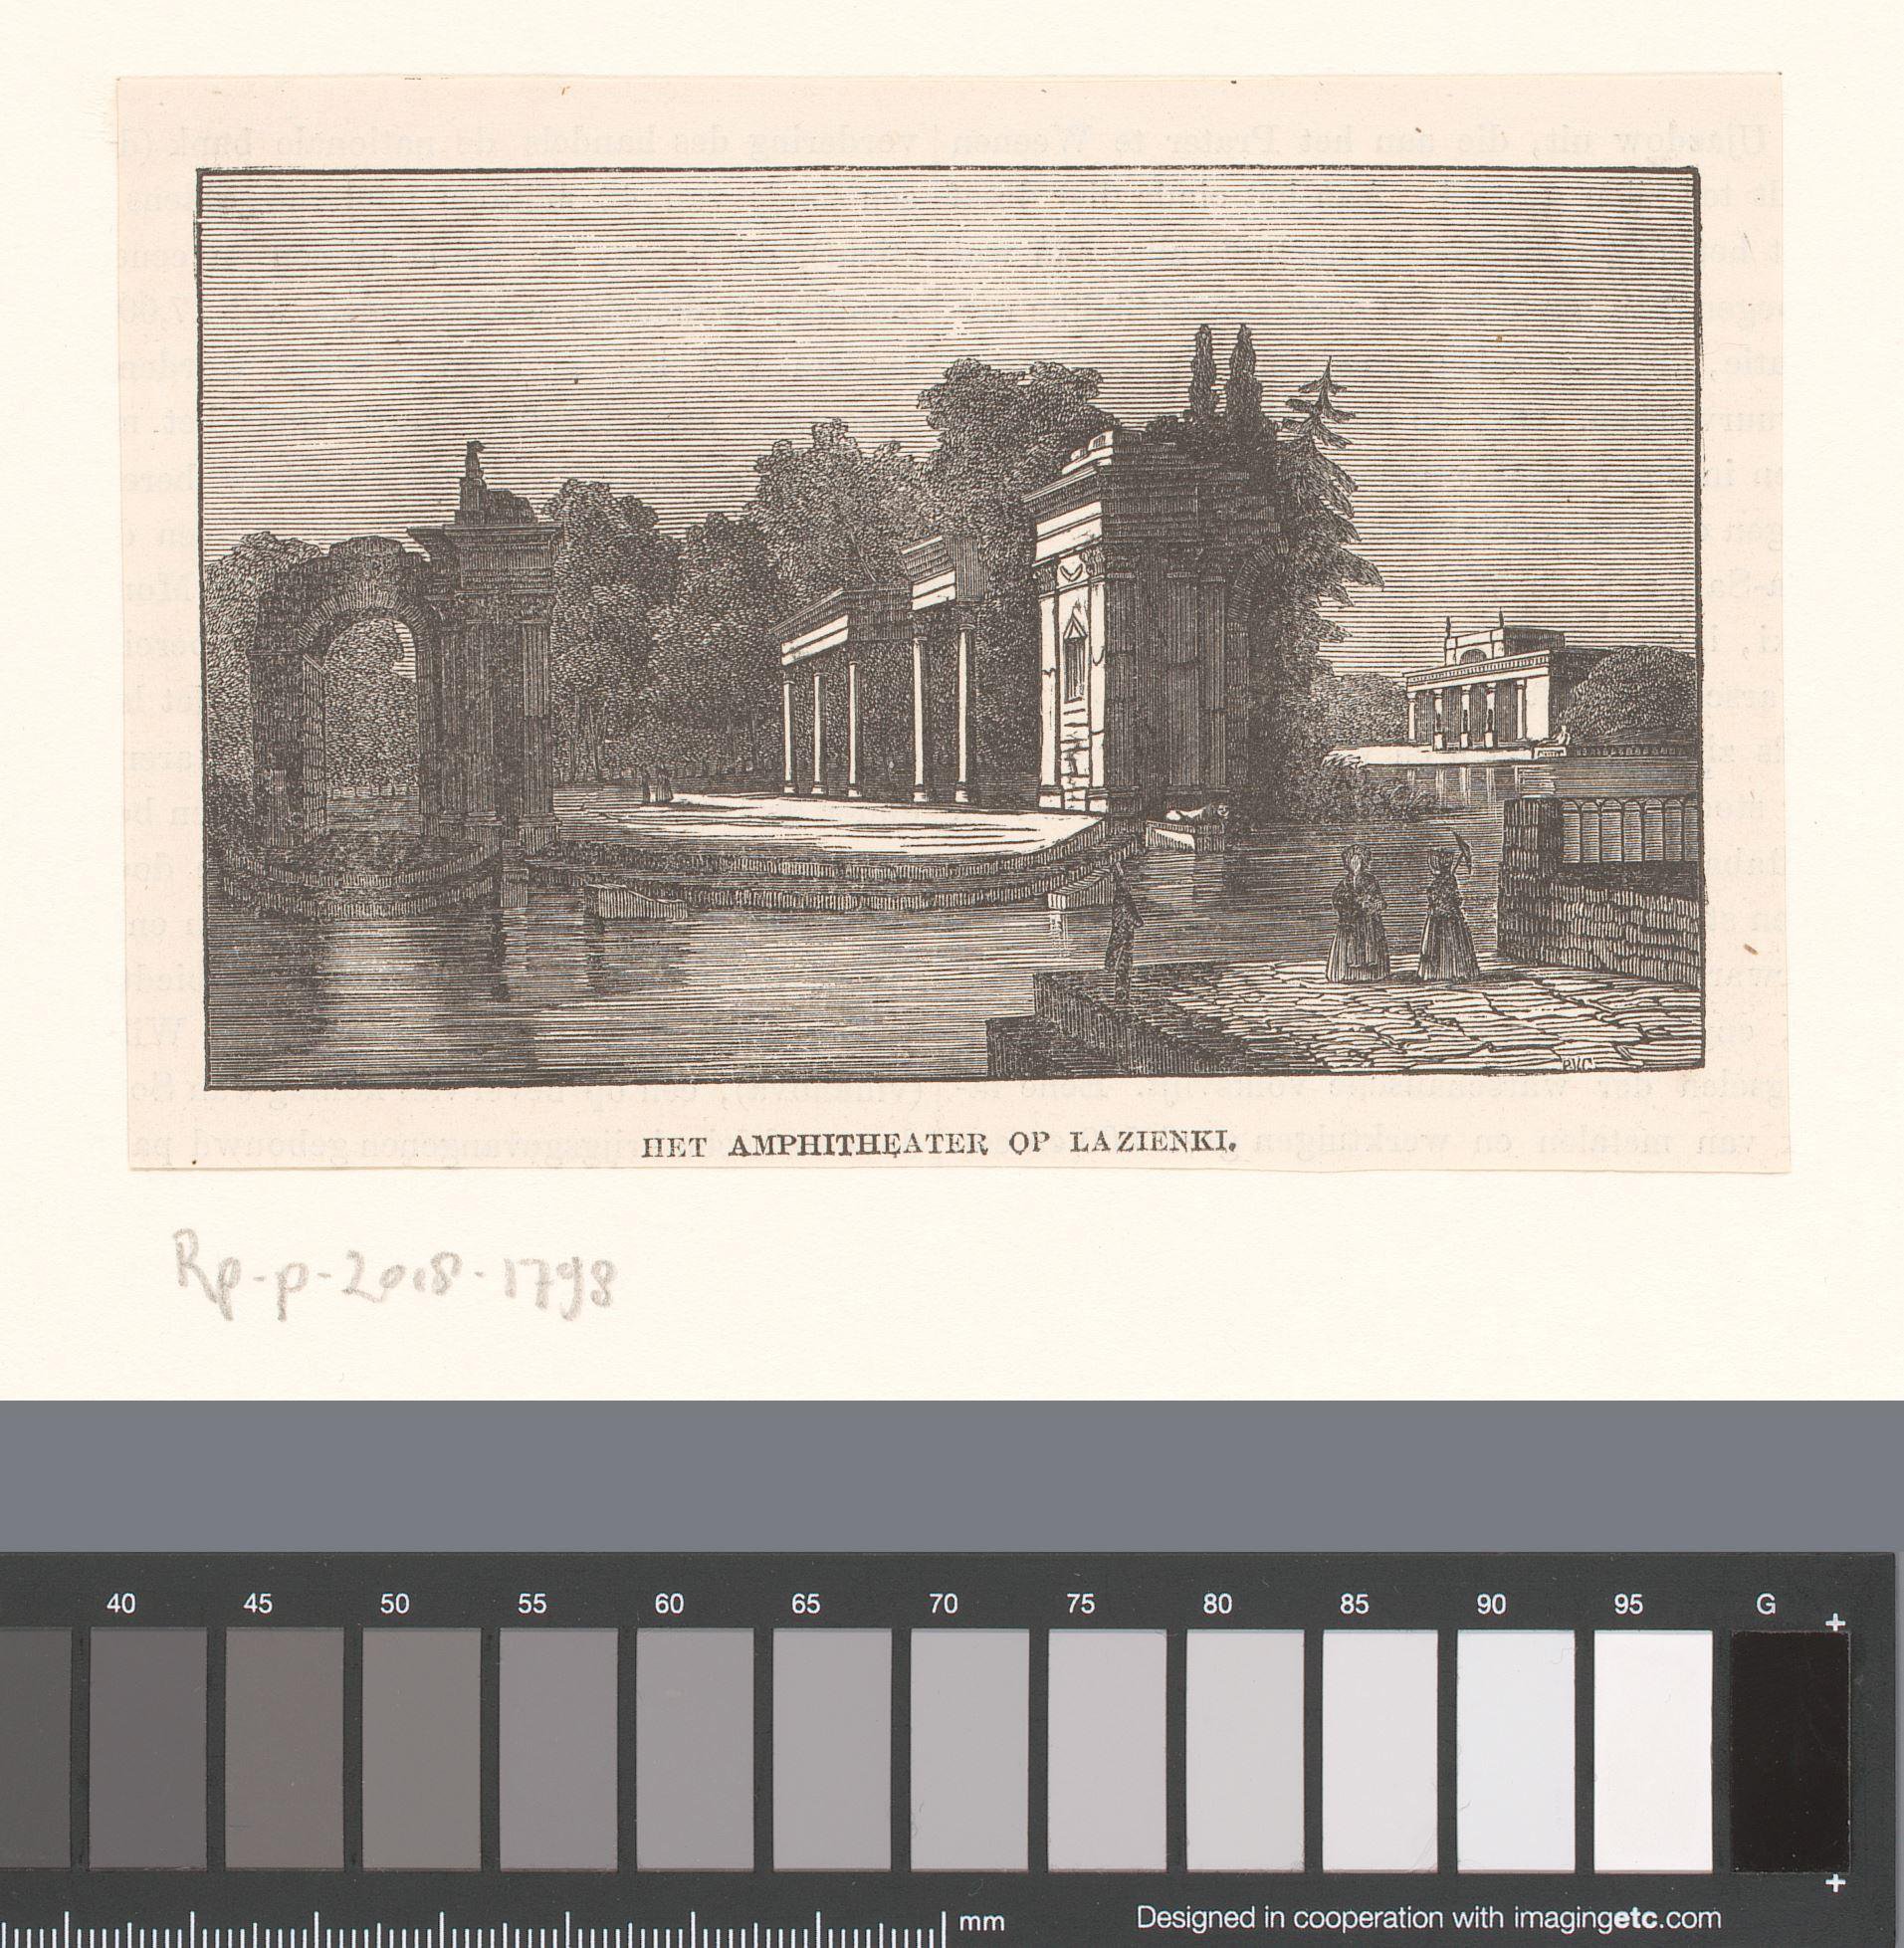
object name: print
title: Gezicht op het amfitheater in het Lazienki Park, te Warschau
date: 1847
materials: paper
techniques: letterpress printing, engraving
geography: amsterdam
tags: park, amphitheatre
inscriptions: collector's mark: Lugt 2228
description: Prent gebruikt in: Witkamp, P.H. Beschrijving van Oost- en Noord-Europa. Amsterdam: J.H. Laarman, 1847.